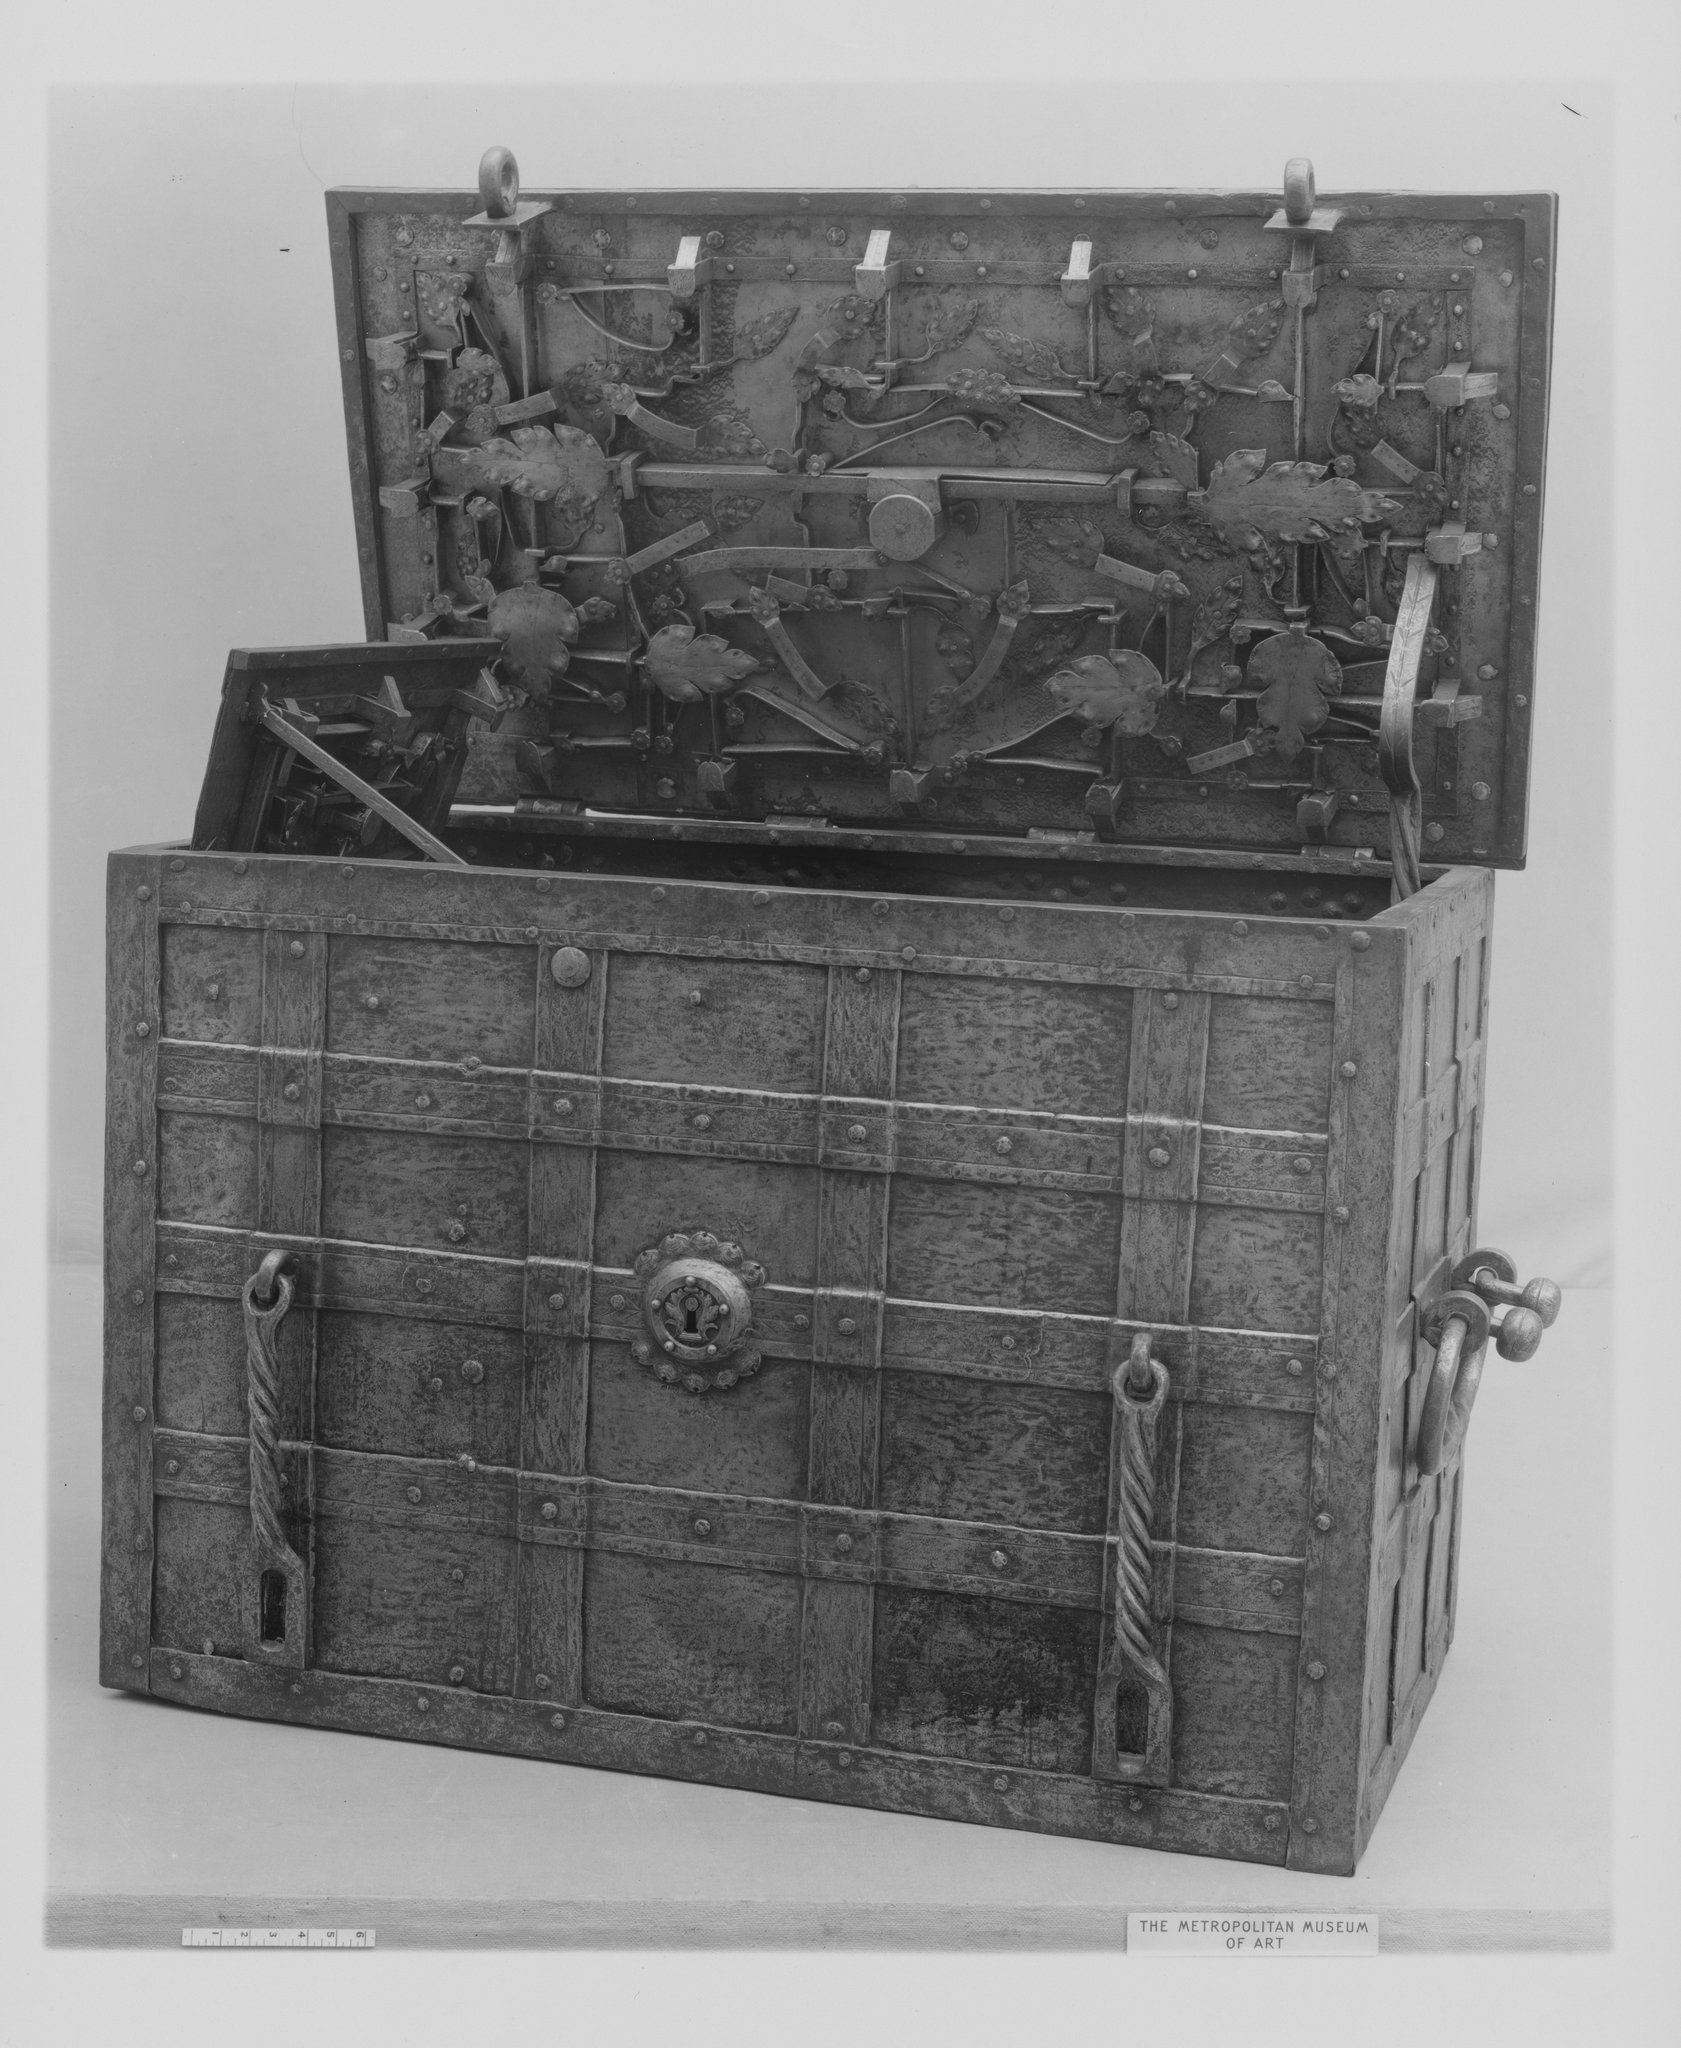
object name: strong box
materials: steel